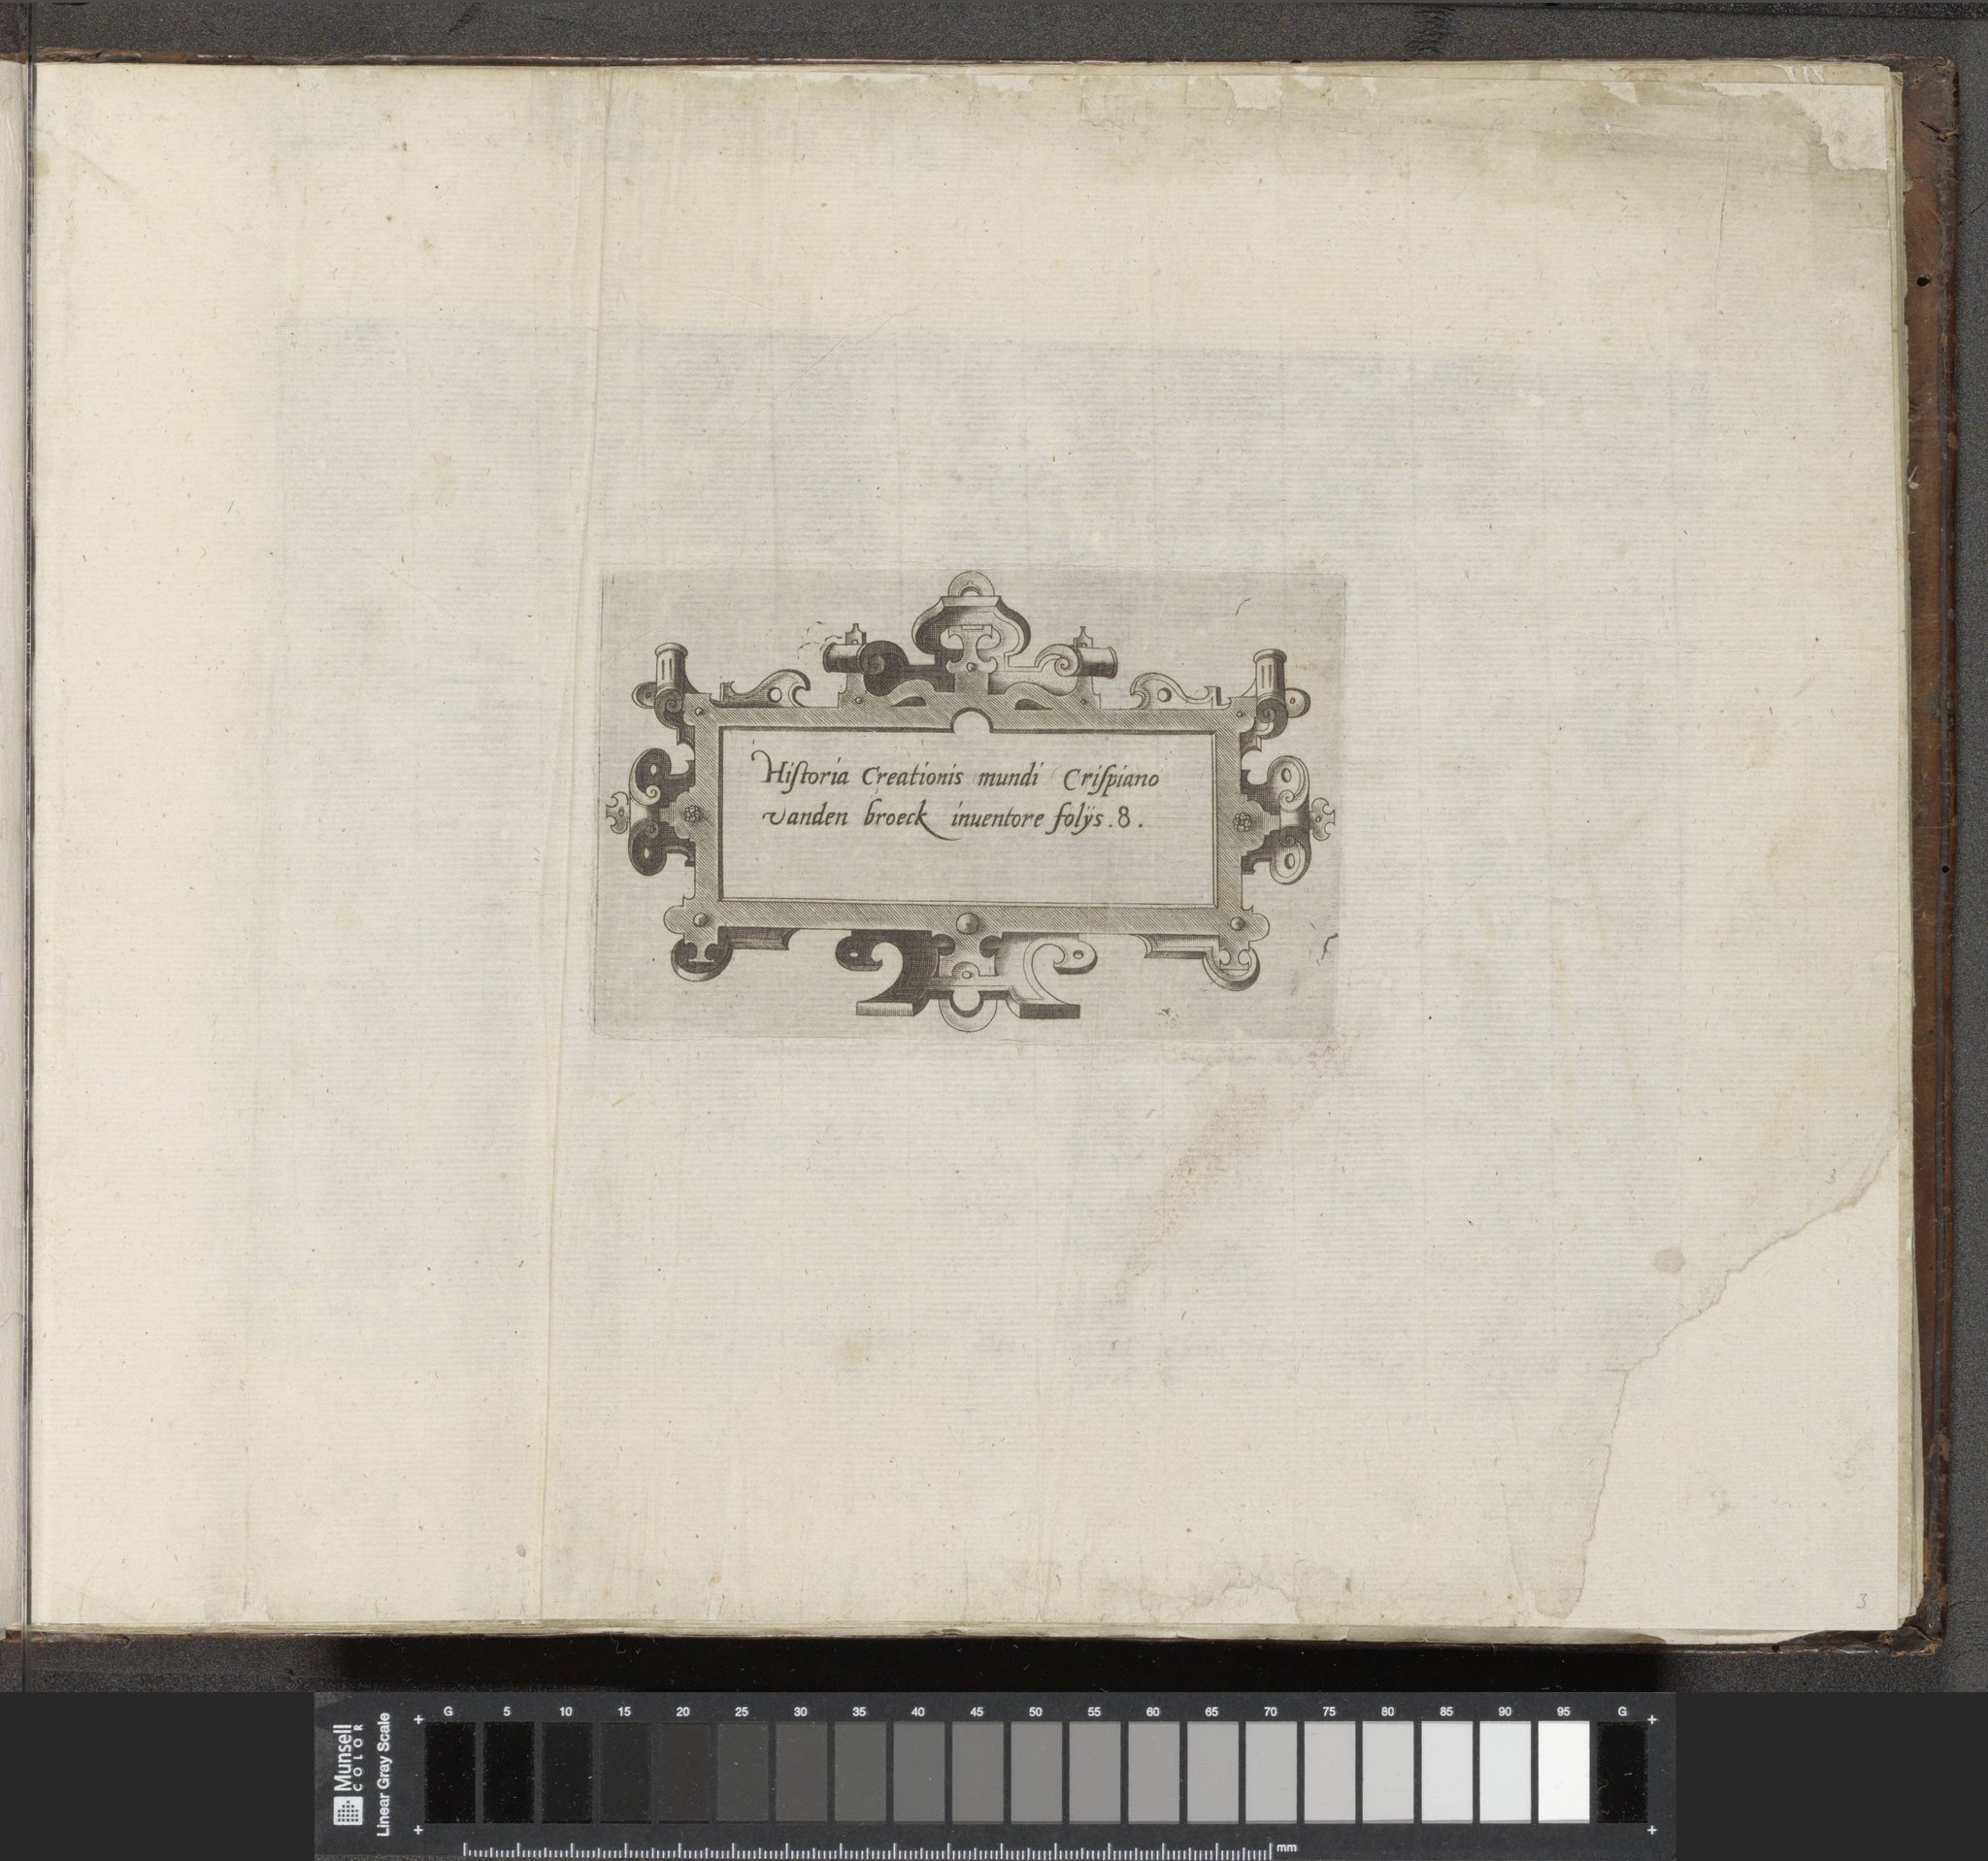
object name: print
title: Historia creationis mundi Crispiano vanden broeck inventore folijs 8.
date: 1579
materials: paper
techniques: engraving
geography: antwerp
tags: scrollwork, strapwork ~ ornament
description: Titel in cartouche met rolwerk. Titelprent voor een serie prenten over de schepping van de wereld. Prent maakt deel uit van een album.